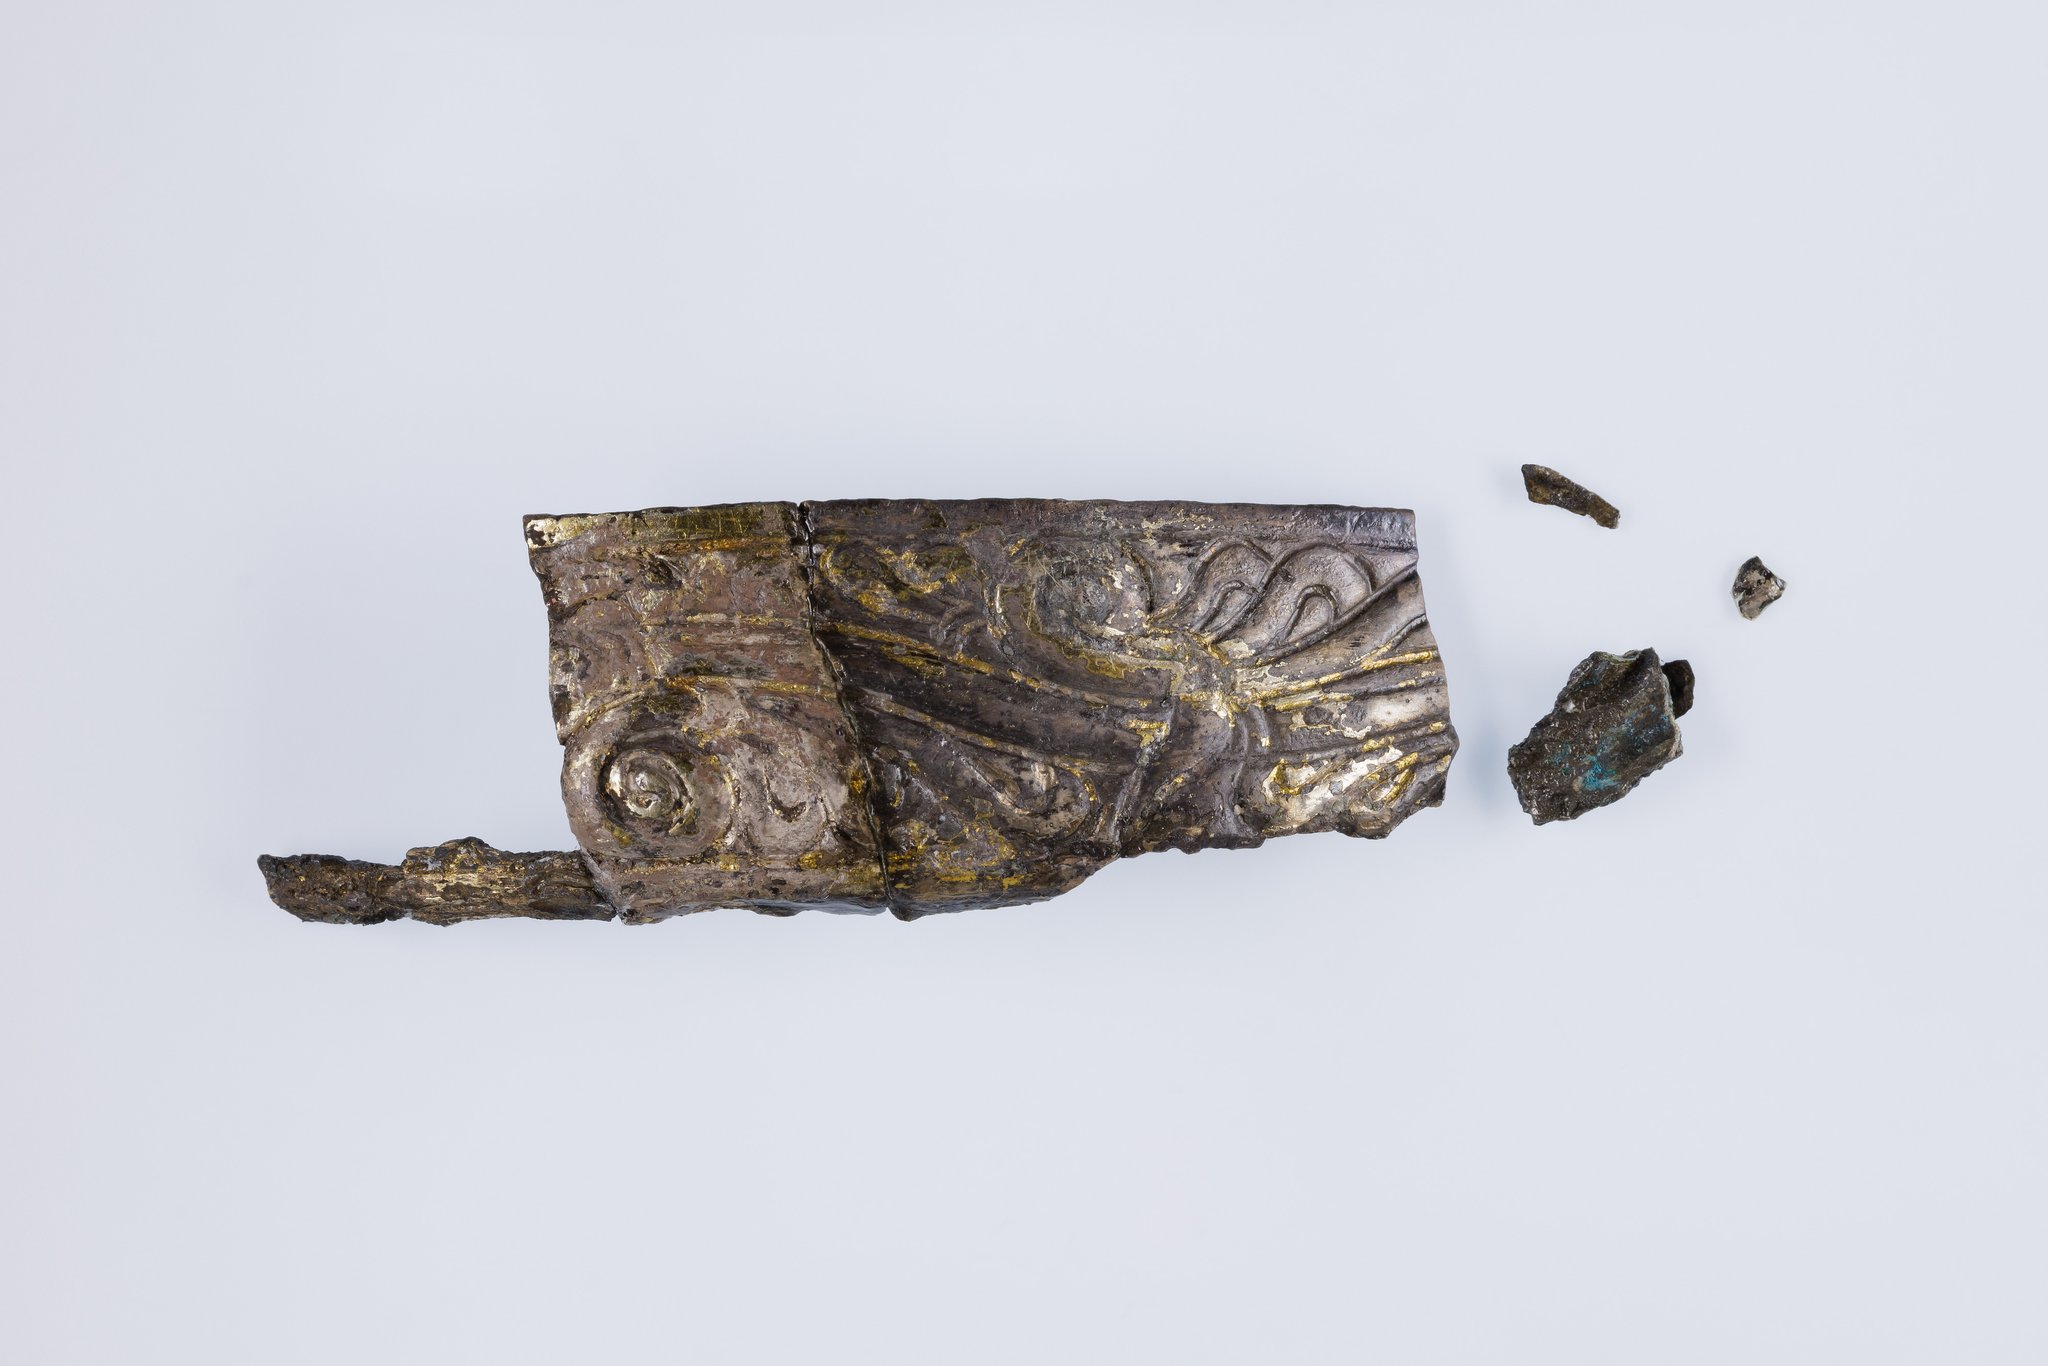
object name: strainer or vase fragment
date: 1295-1070 BCE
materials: silver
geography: egypt